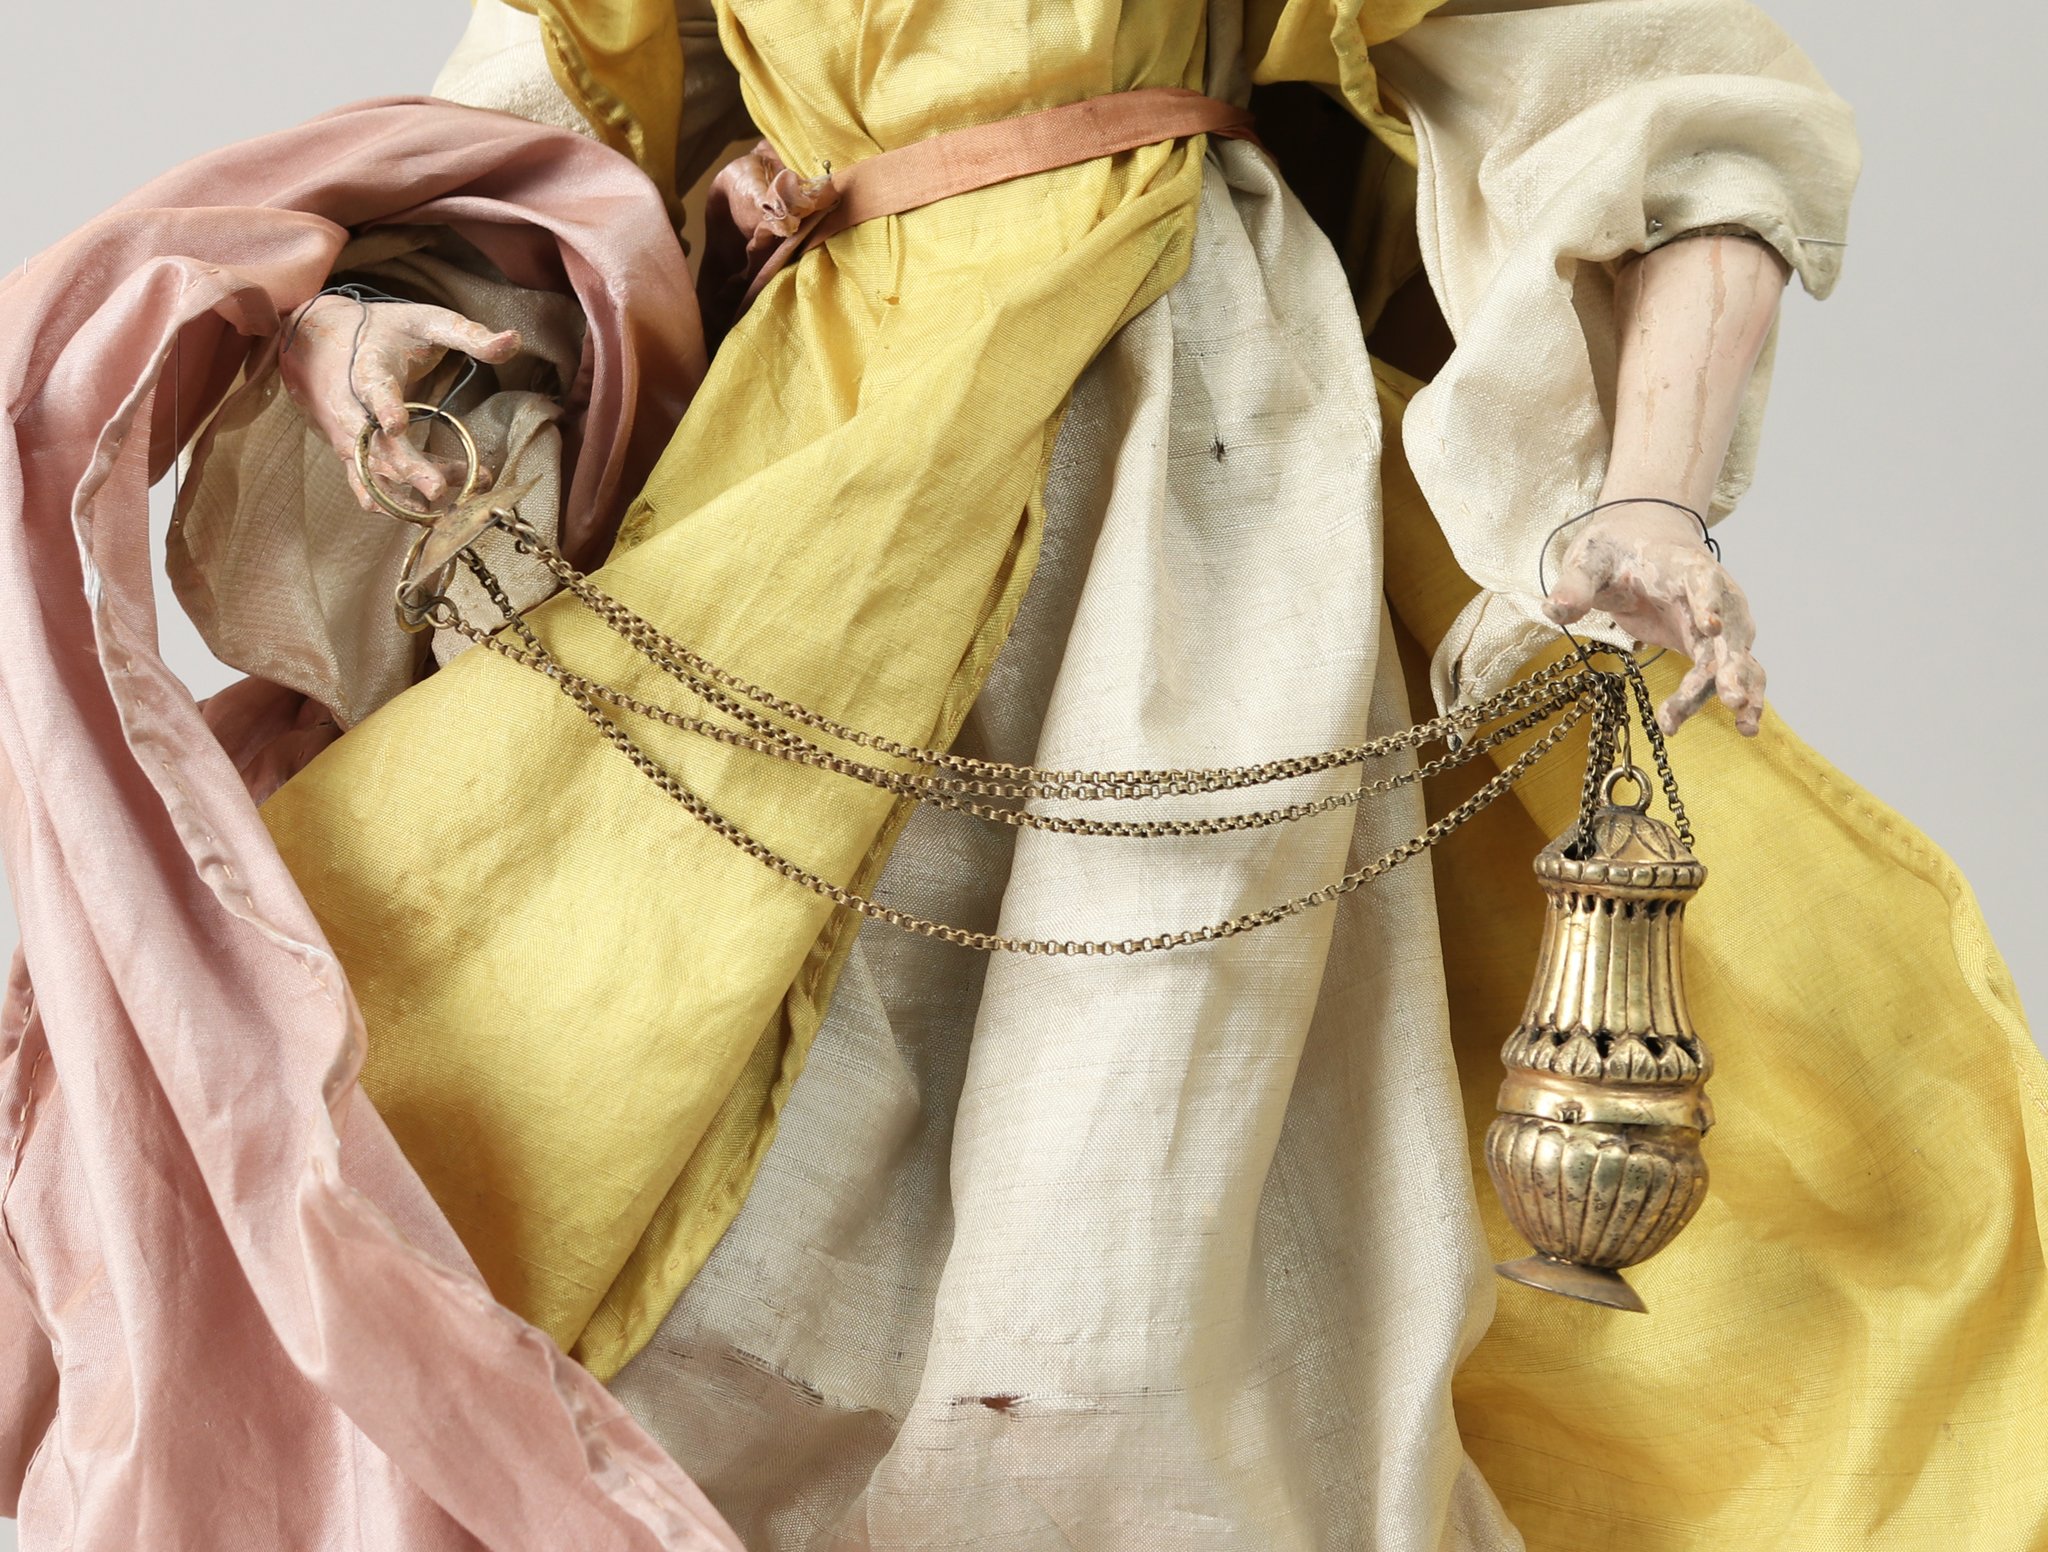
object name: crèche figure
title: Censer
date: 1751-1800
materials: silver gilt